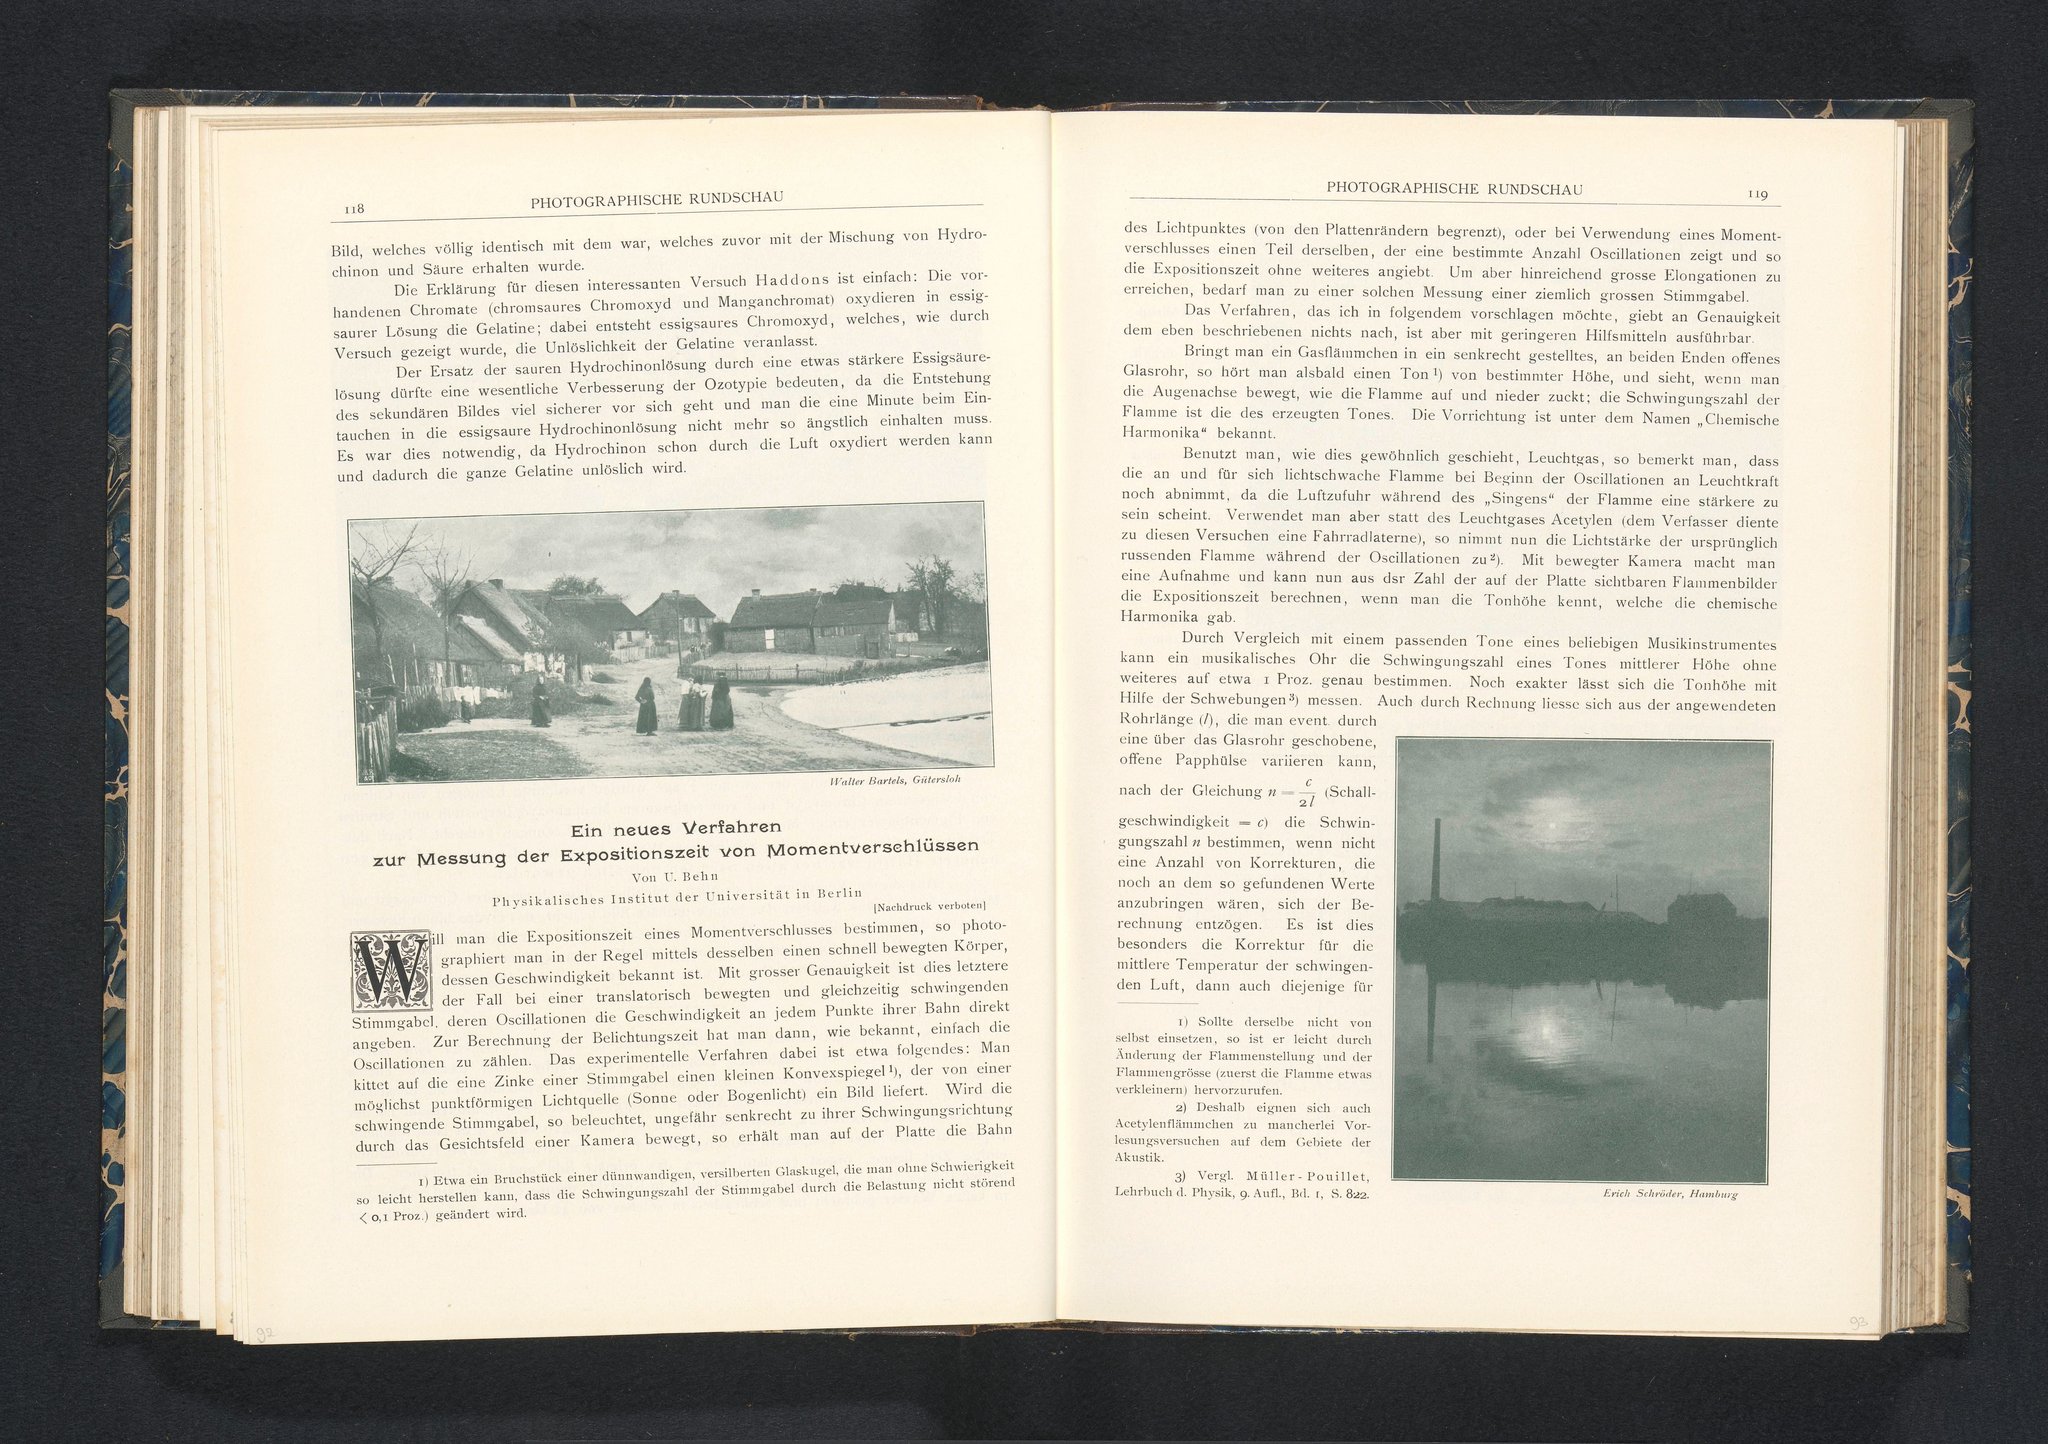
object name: photomechanical print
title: Groep mensen op straat in een dorpje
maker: walter bartels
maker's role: fotograaf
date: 1896-1901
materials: paper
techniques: autotype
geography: berlin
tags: village